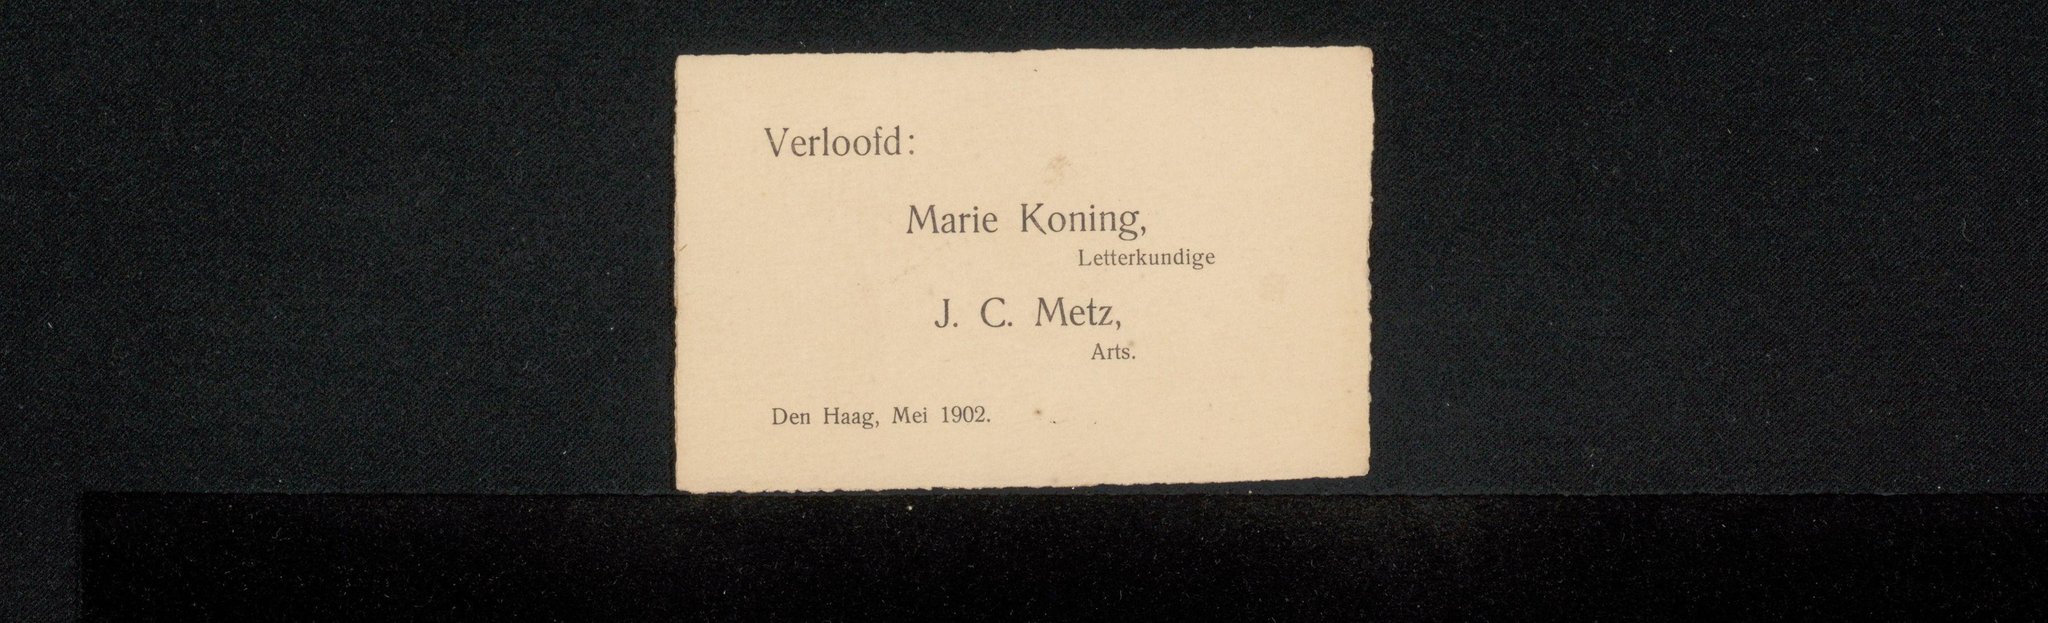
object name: wedding announcement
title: Verlovingsaankondiging aan Philip Zilcken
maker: Anonymous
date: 1902-1905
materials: cardboard, ink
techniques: pen, writing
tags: marie metz-koning, the hague, draughtsman, philip zilcken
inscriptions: collector's mark: ‘RPK’